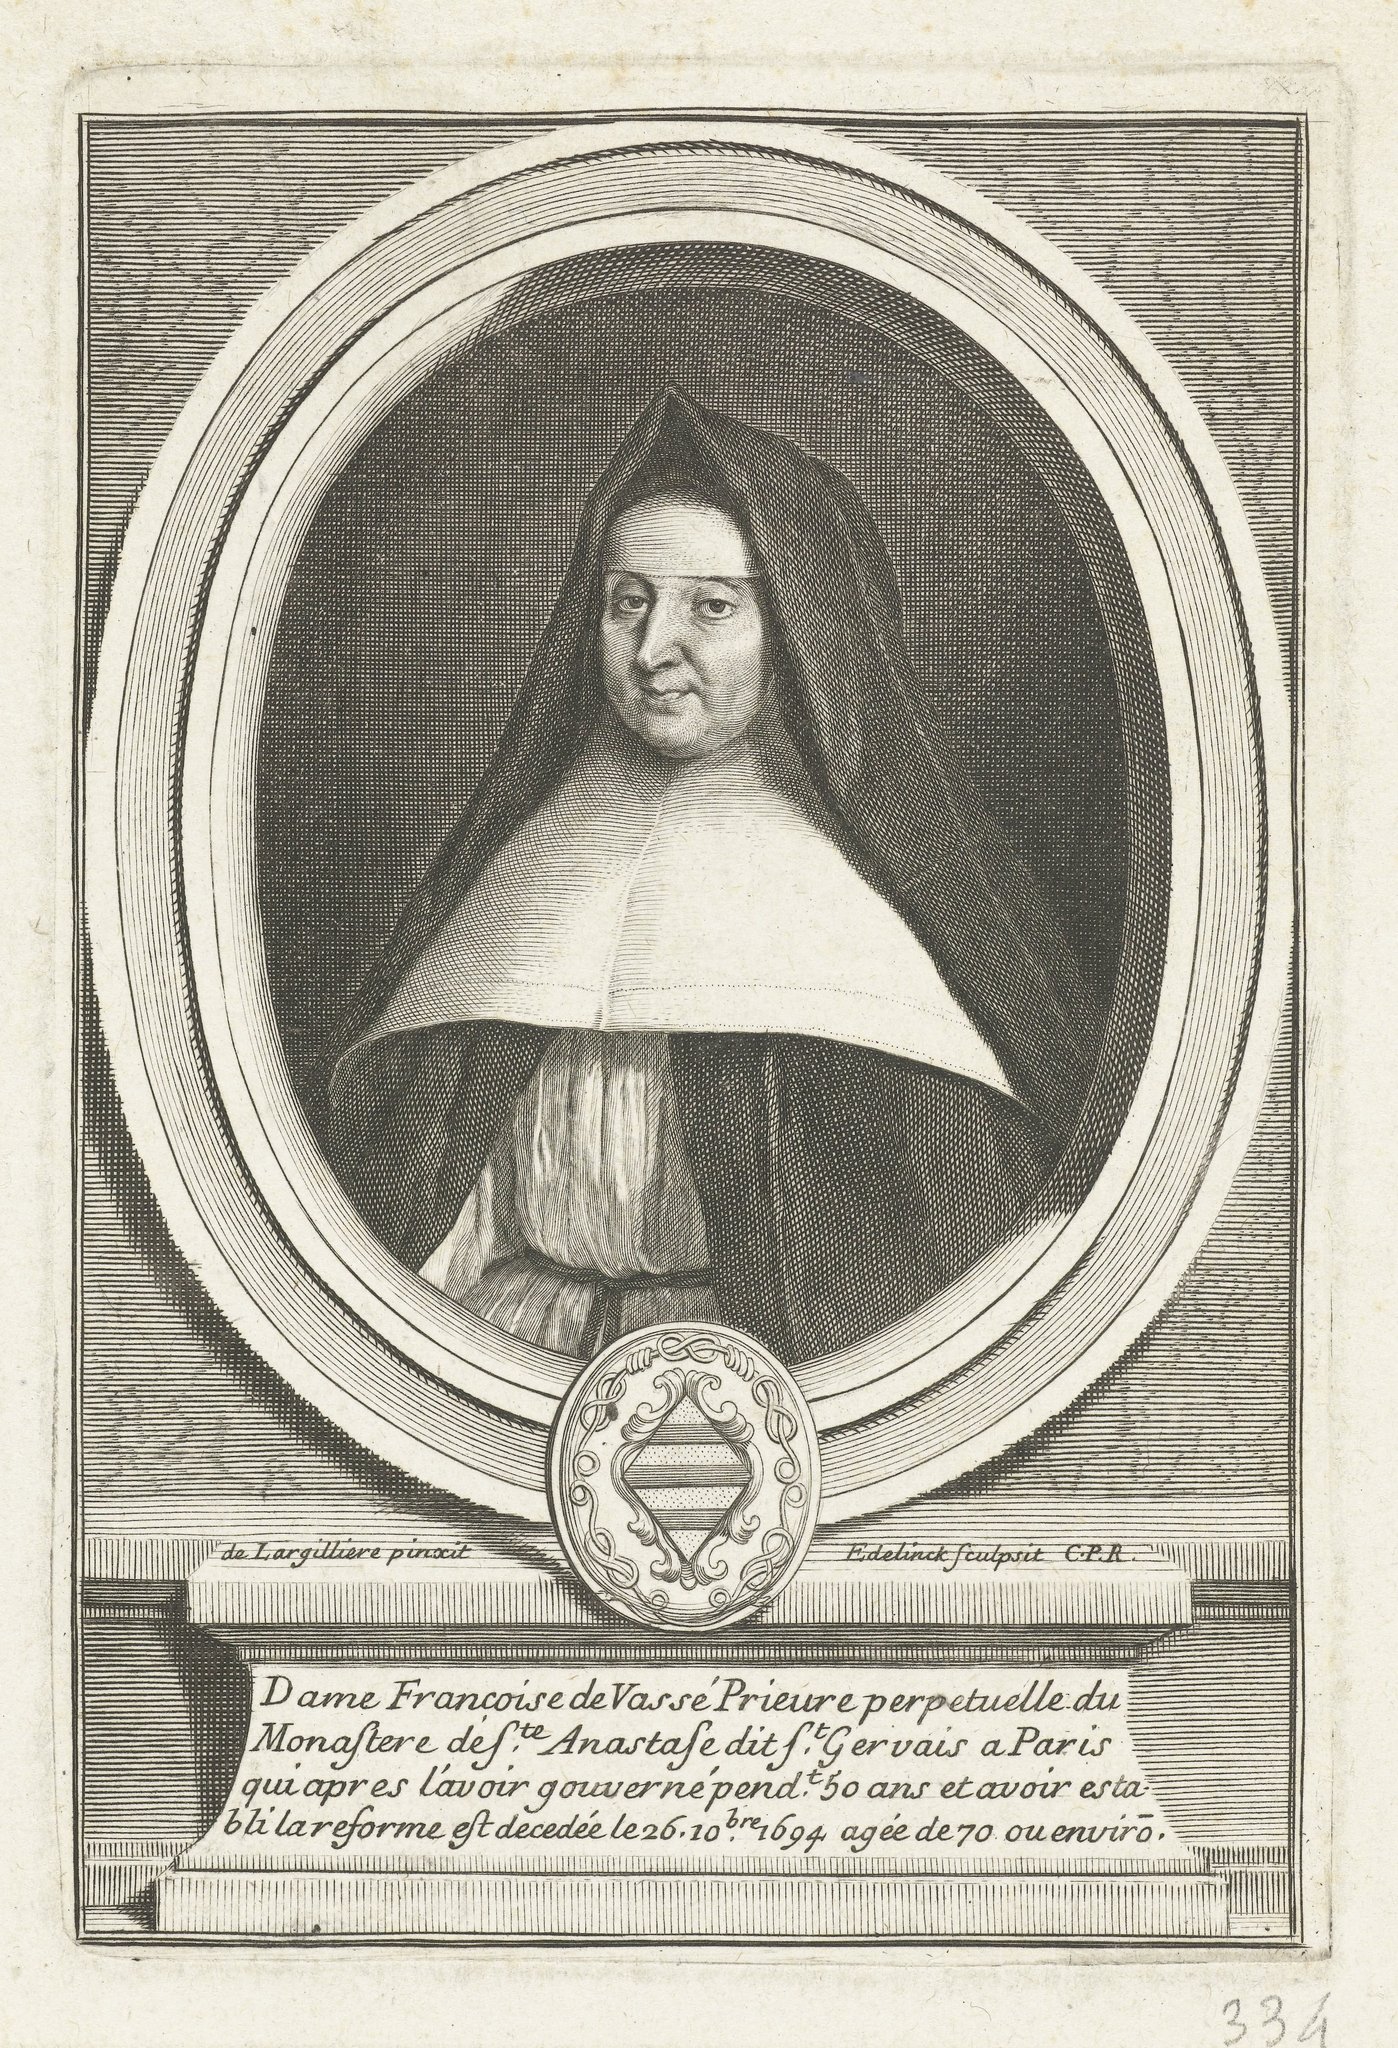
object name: print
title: Portret van Françoise de Vassé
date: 1694-1707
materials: paper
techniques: engraving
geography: paris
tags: françoise de vassé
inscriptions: collector's mark: Lugt 240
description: Portret van de Franse kloosteroverste Françoise de Vassé, afgebeeld in ovale omlijsting met wapen. Onder de lijst een console met een Franse tekst van vier regels.